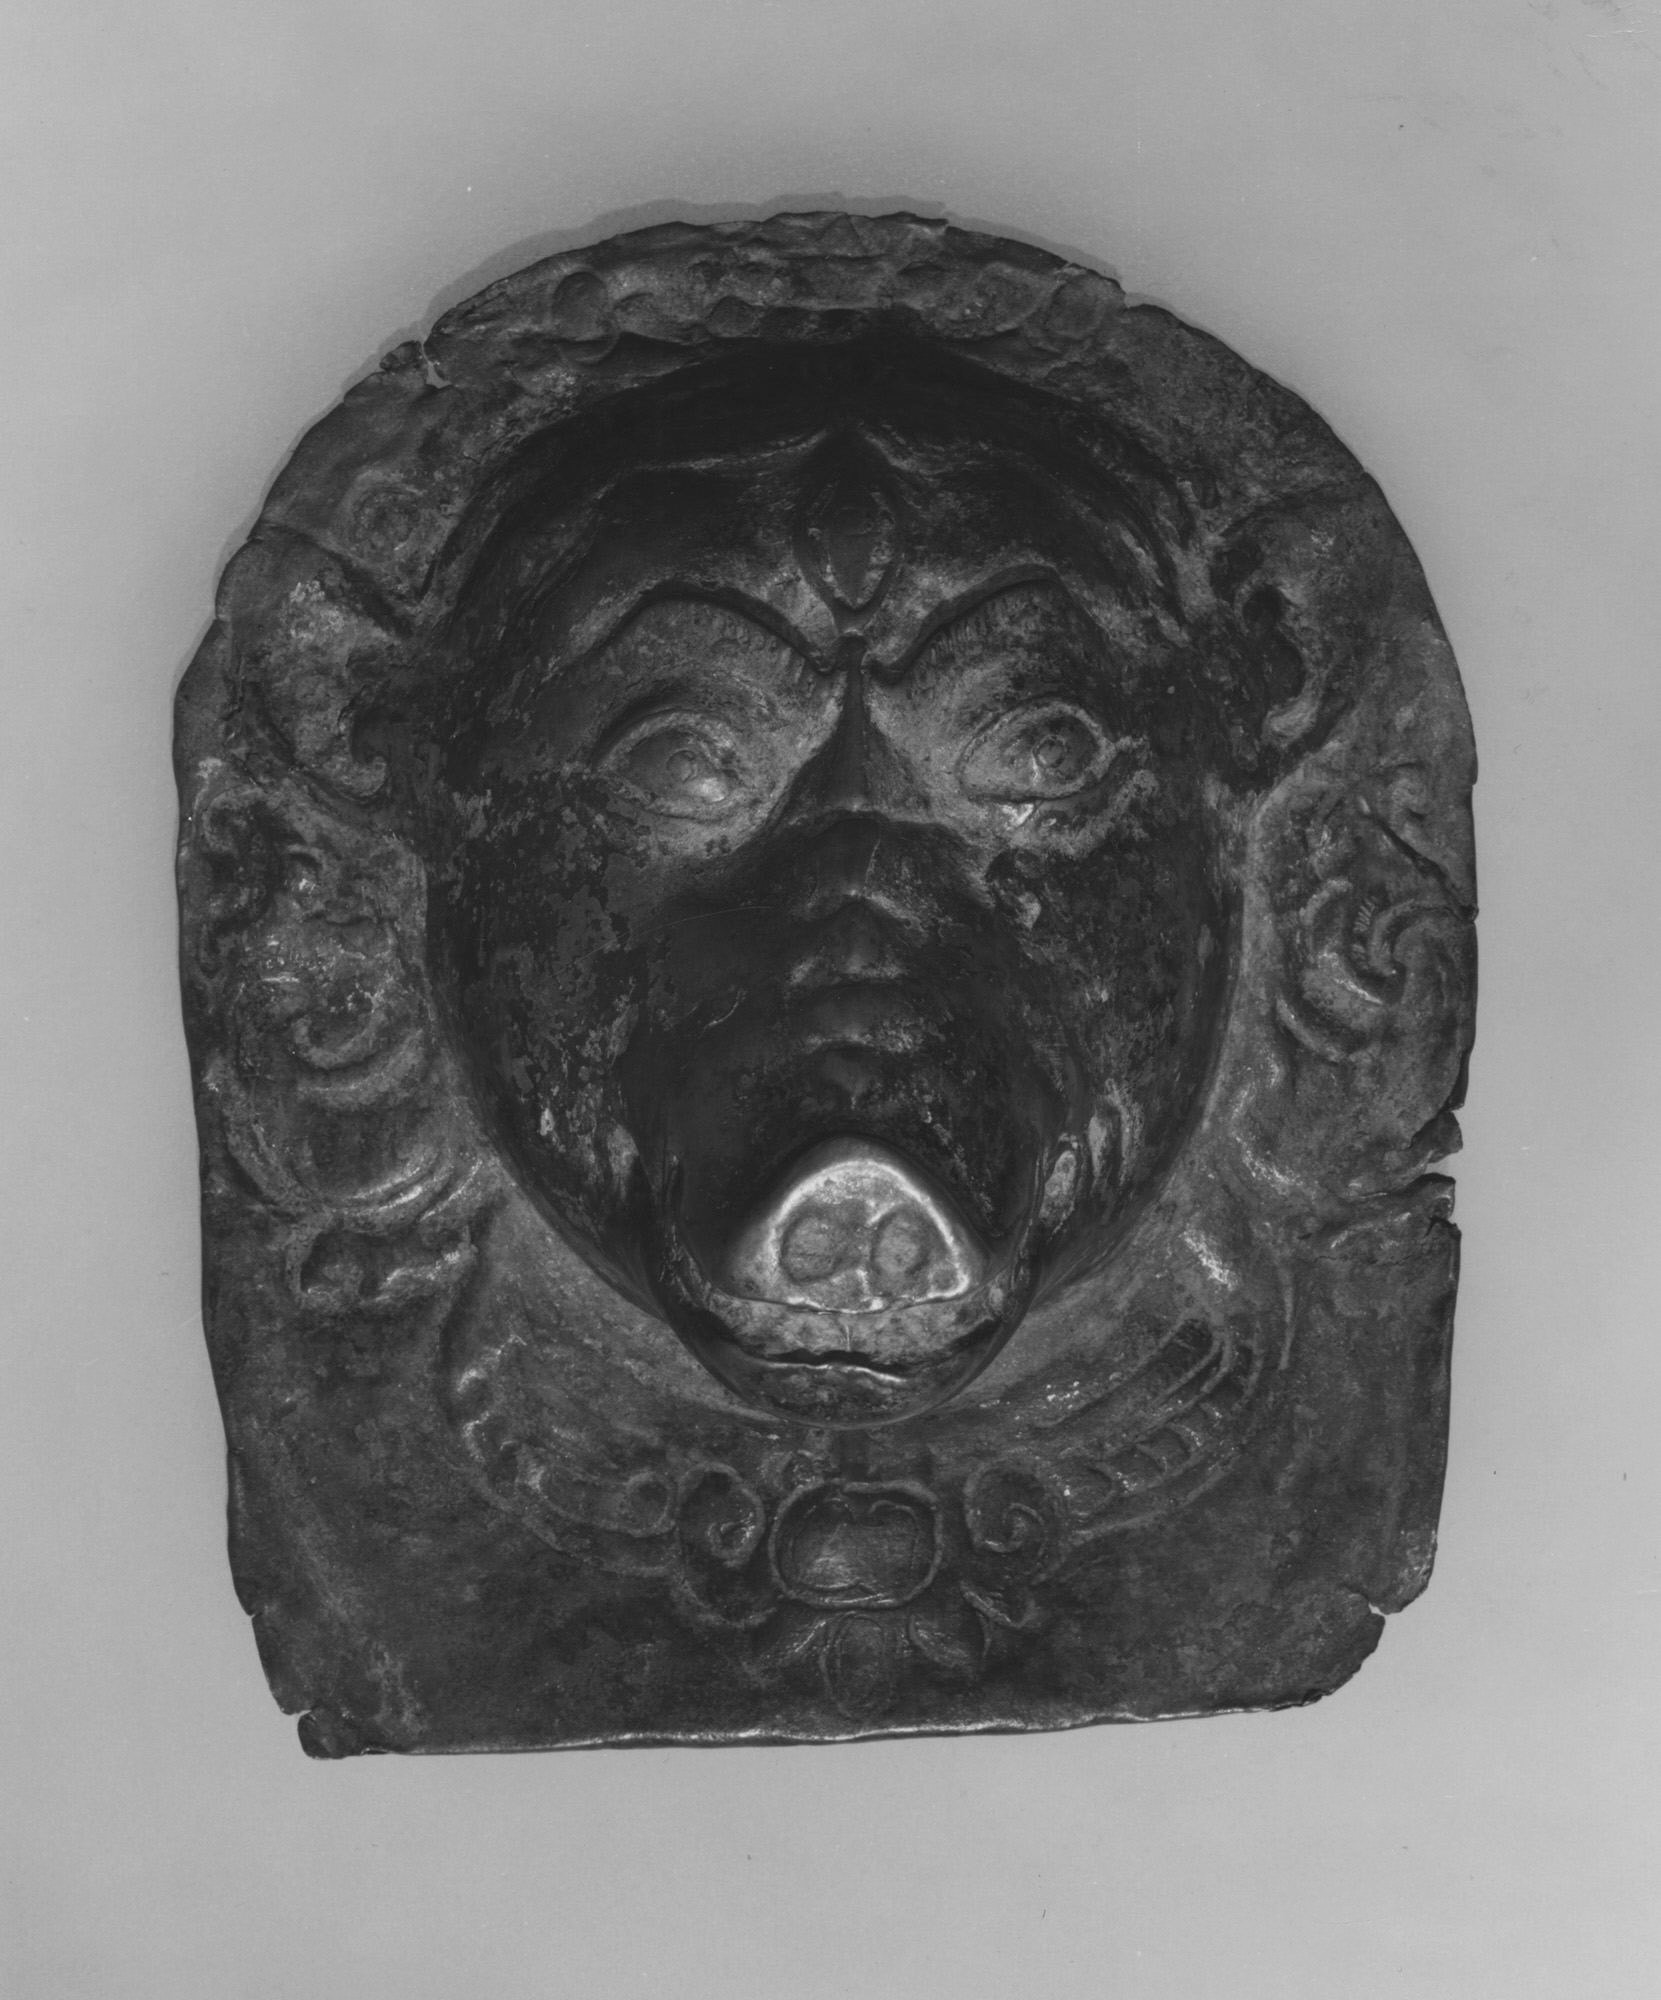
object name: relief plaque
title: Relief Plaque of Hindu Deity, Probably Processional: Face of Varaha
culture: nepali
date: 1301-1600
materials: copper alloy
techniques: repoussé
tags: faces,hinduism